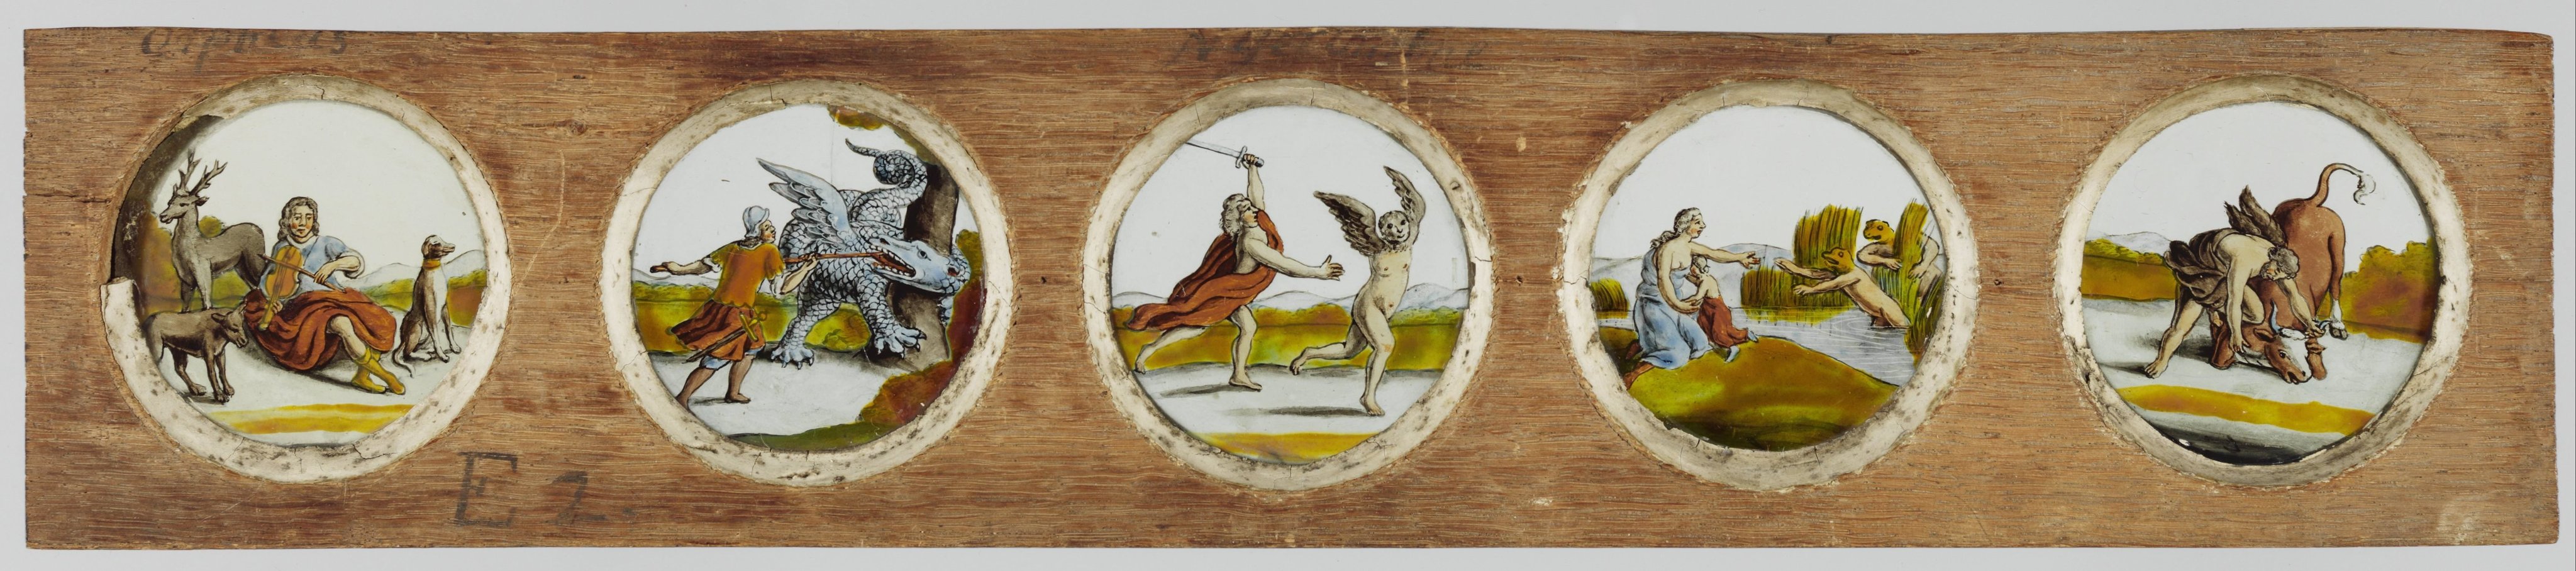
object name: lantern slide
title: Vijf taferelen uit de klassieke mythologie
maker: Anonymous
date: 1700-1790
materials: glass, wood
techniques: painted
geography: netherlands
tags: (7) the cretan bull is captured by hercules, orpheus playing the lyre: trees and rocks move, beasts and birds are enchanted, lycian farmers changed into frogs: latona changes lycian farmers into frogs, because while they were weeding a marsh, they prevented her and her children from quenching their thirst (ovid, metamorphoses vi 369)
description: Vijf glazen met taferelen uit de klassieke mythologie in een houten vatting. Het glas uiterst links: Orpheus speelt op een Renaissanceviool, om hem heen zitten een hert en twee honden te luisteren. Het glas rechts daarvan: man met speer en in klassieke wapenrusting, in gevecht met een draak. Het middelste glas: man met een rode doek omgeslagen achtervolgt met zwaard een vrouwfiguur met vleugels in plaats van armen (waarschijnlijk een harpij, achtervolgd door Boreas of Jason). Het glas rechts daarvan: een vrouw, met een verschrikt kind in haar armen, wijst naar mannen met kikvorshooefden in een poel met riet. (Waarschijnlijk de landmannen die door de godin Latona in kikkers werden veranderd nadat ze haar hadden beledigd.) Het glas uiterst rechts: Hercules vangt de stier van Kreta. Hercules heeft het hoofd van de stier tegen de grond gewerkt en zit met zijn knie op diens nek.